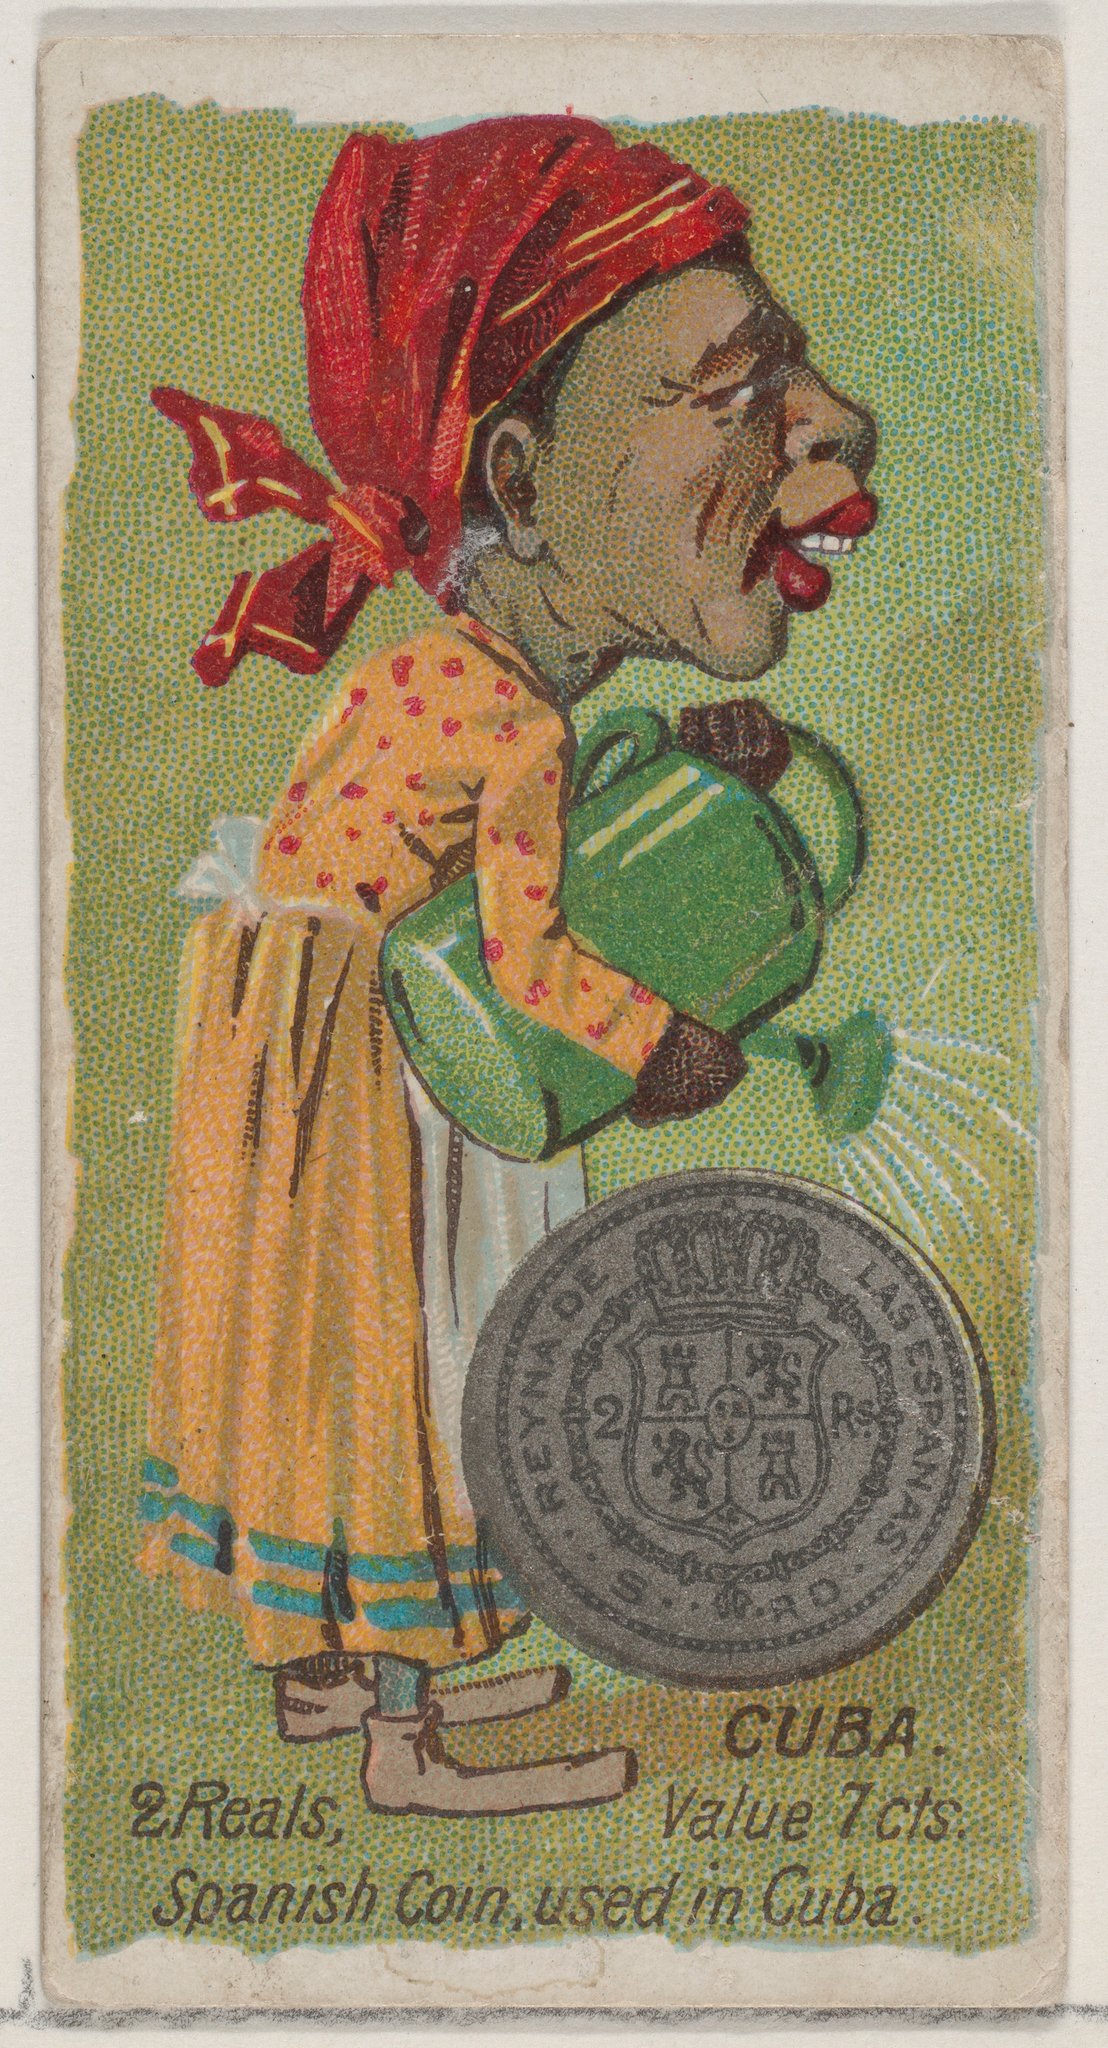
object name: print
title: Caricatured Cuban, 2 Reals, from the series Coins of All Nations (N72, variation 2) for Duke brand cigarettes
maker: w. duke, sons & co.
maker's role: publisher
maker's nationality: american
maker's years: 1870-1920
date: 1889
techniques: color lithograph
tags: women,coins